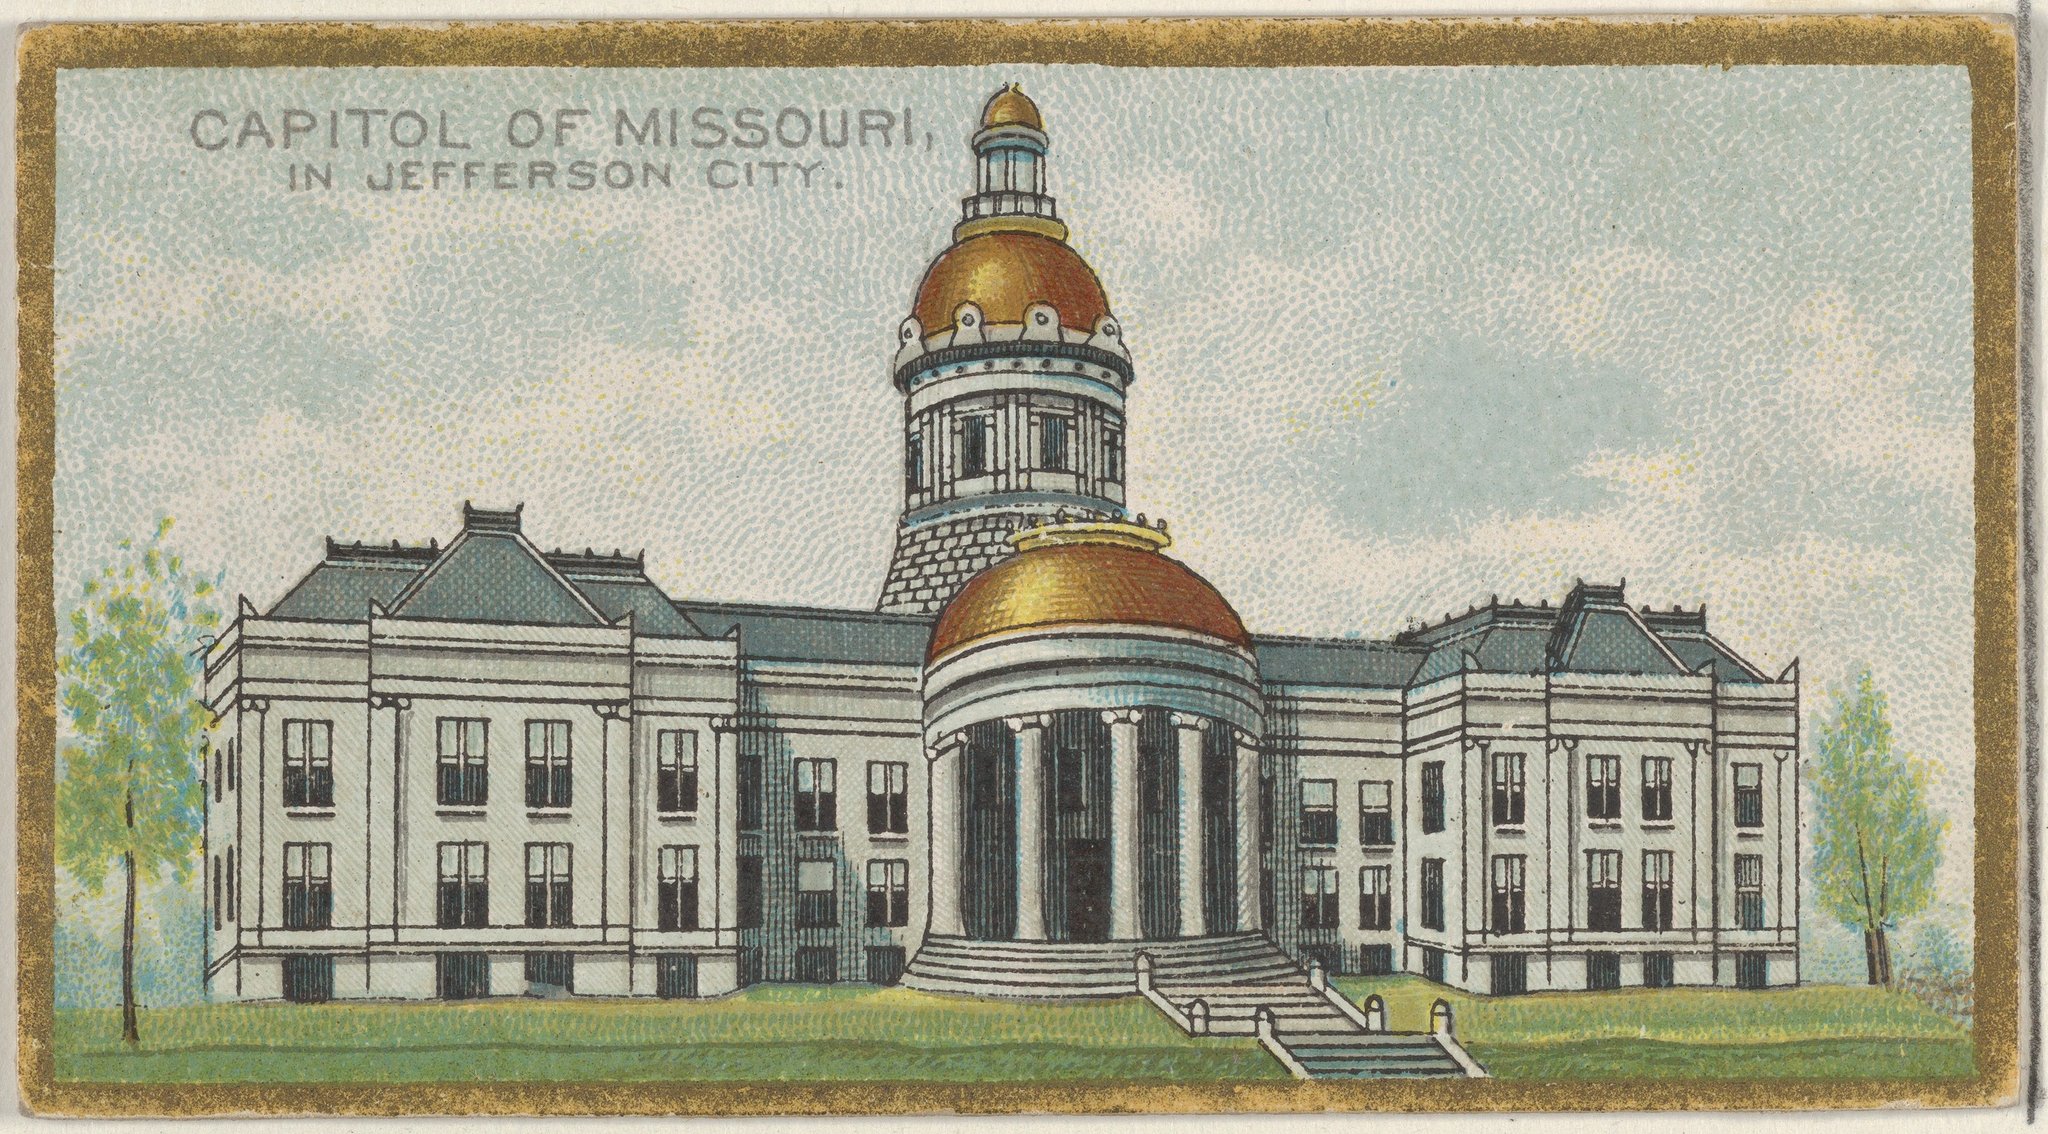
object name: print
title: Capitol of Missouri in Jefferson City, from the General Government and State Capitol Buildings series (N14) for Allen & Ginter Cigarettes Brands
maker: allen & ginter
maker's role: publisher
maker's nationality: american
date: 1889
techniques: color lithograph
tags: buildings